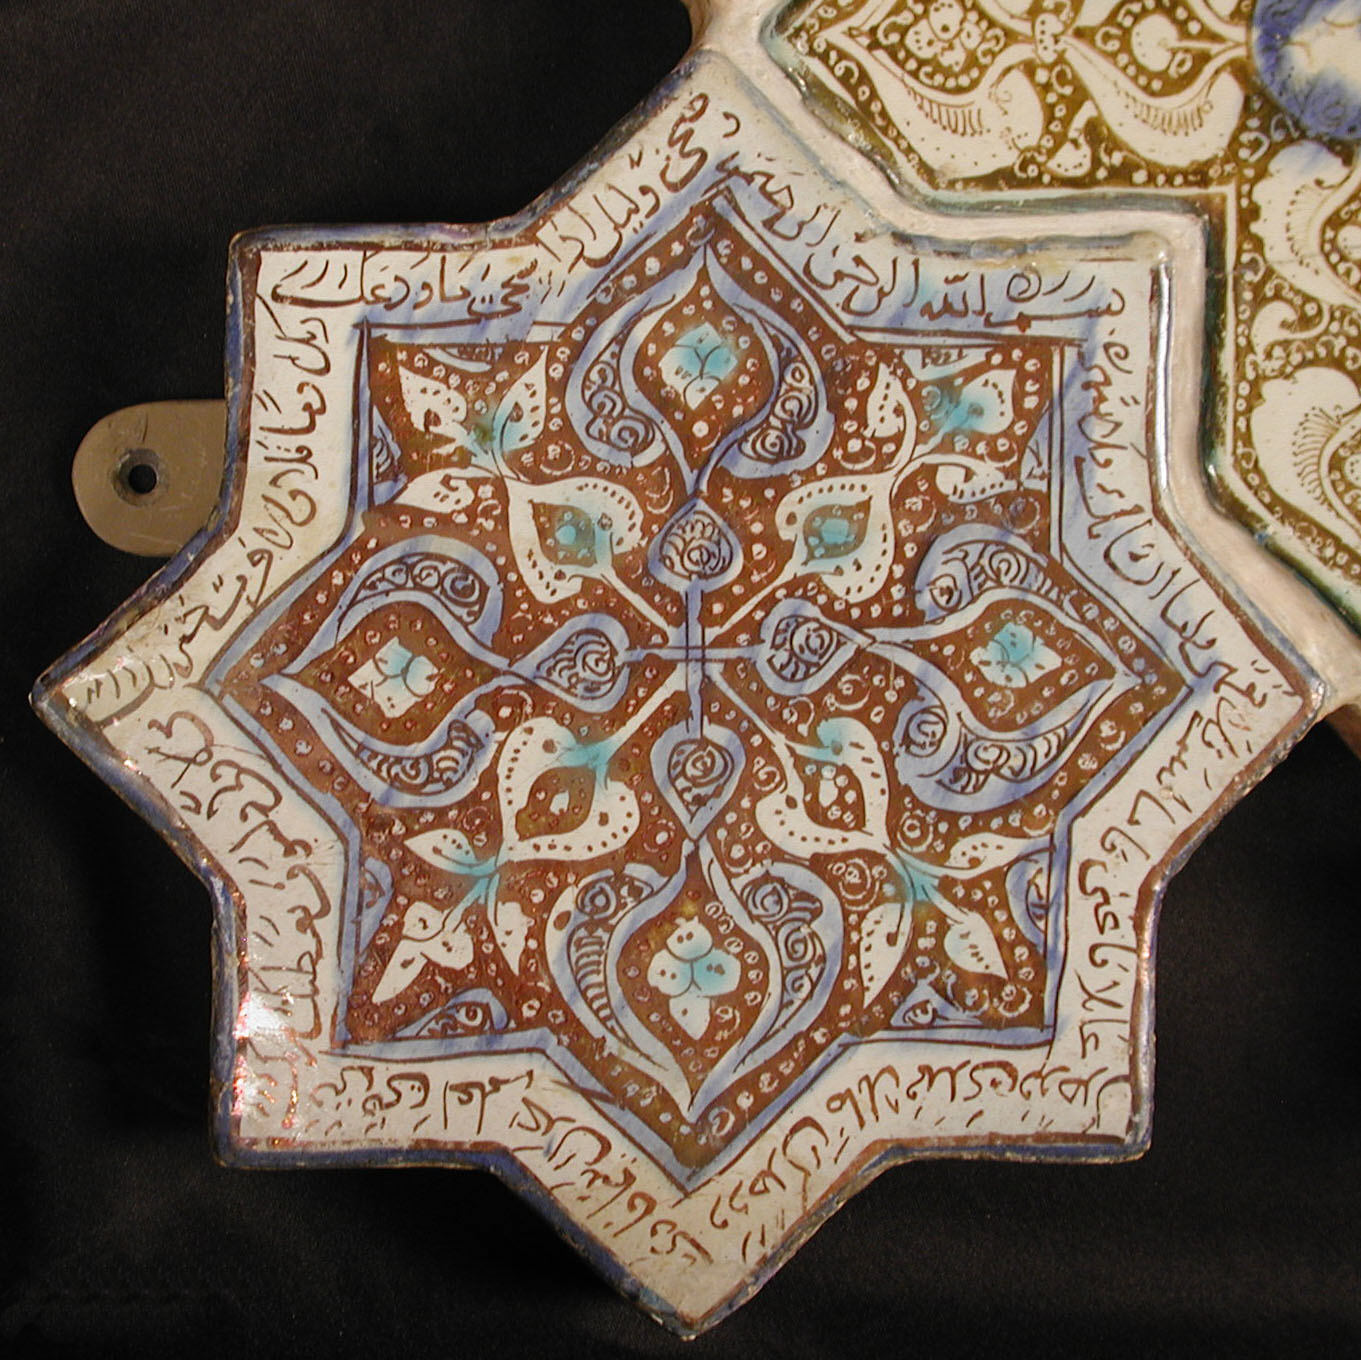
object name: tile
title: Star-Shaped Tile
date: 1201-1400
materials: glaze, stonepaste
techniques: luster painting, painting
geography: iran